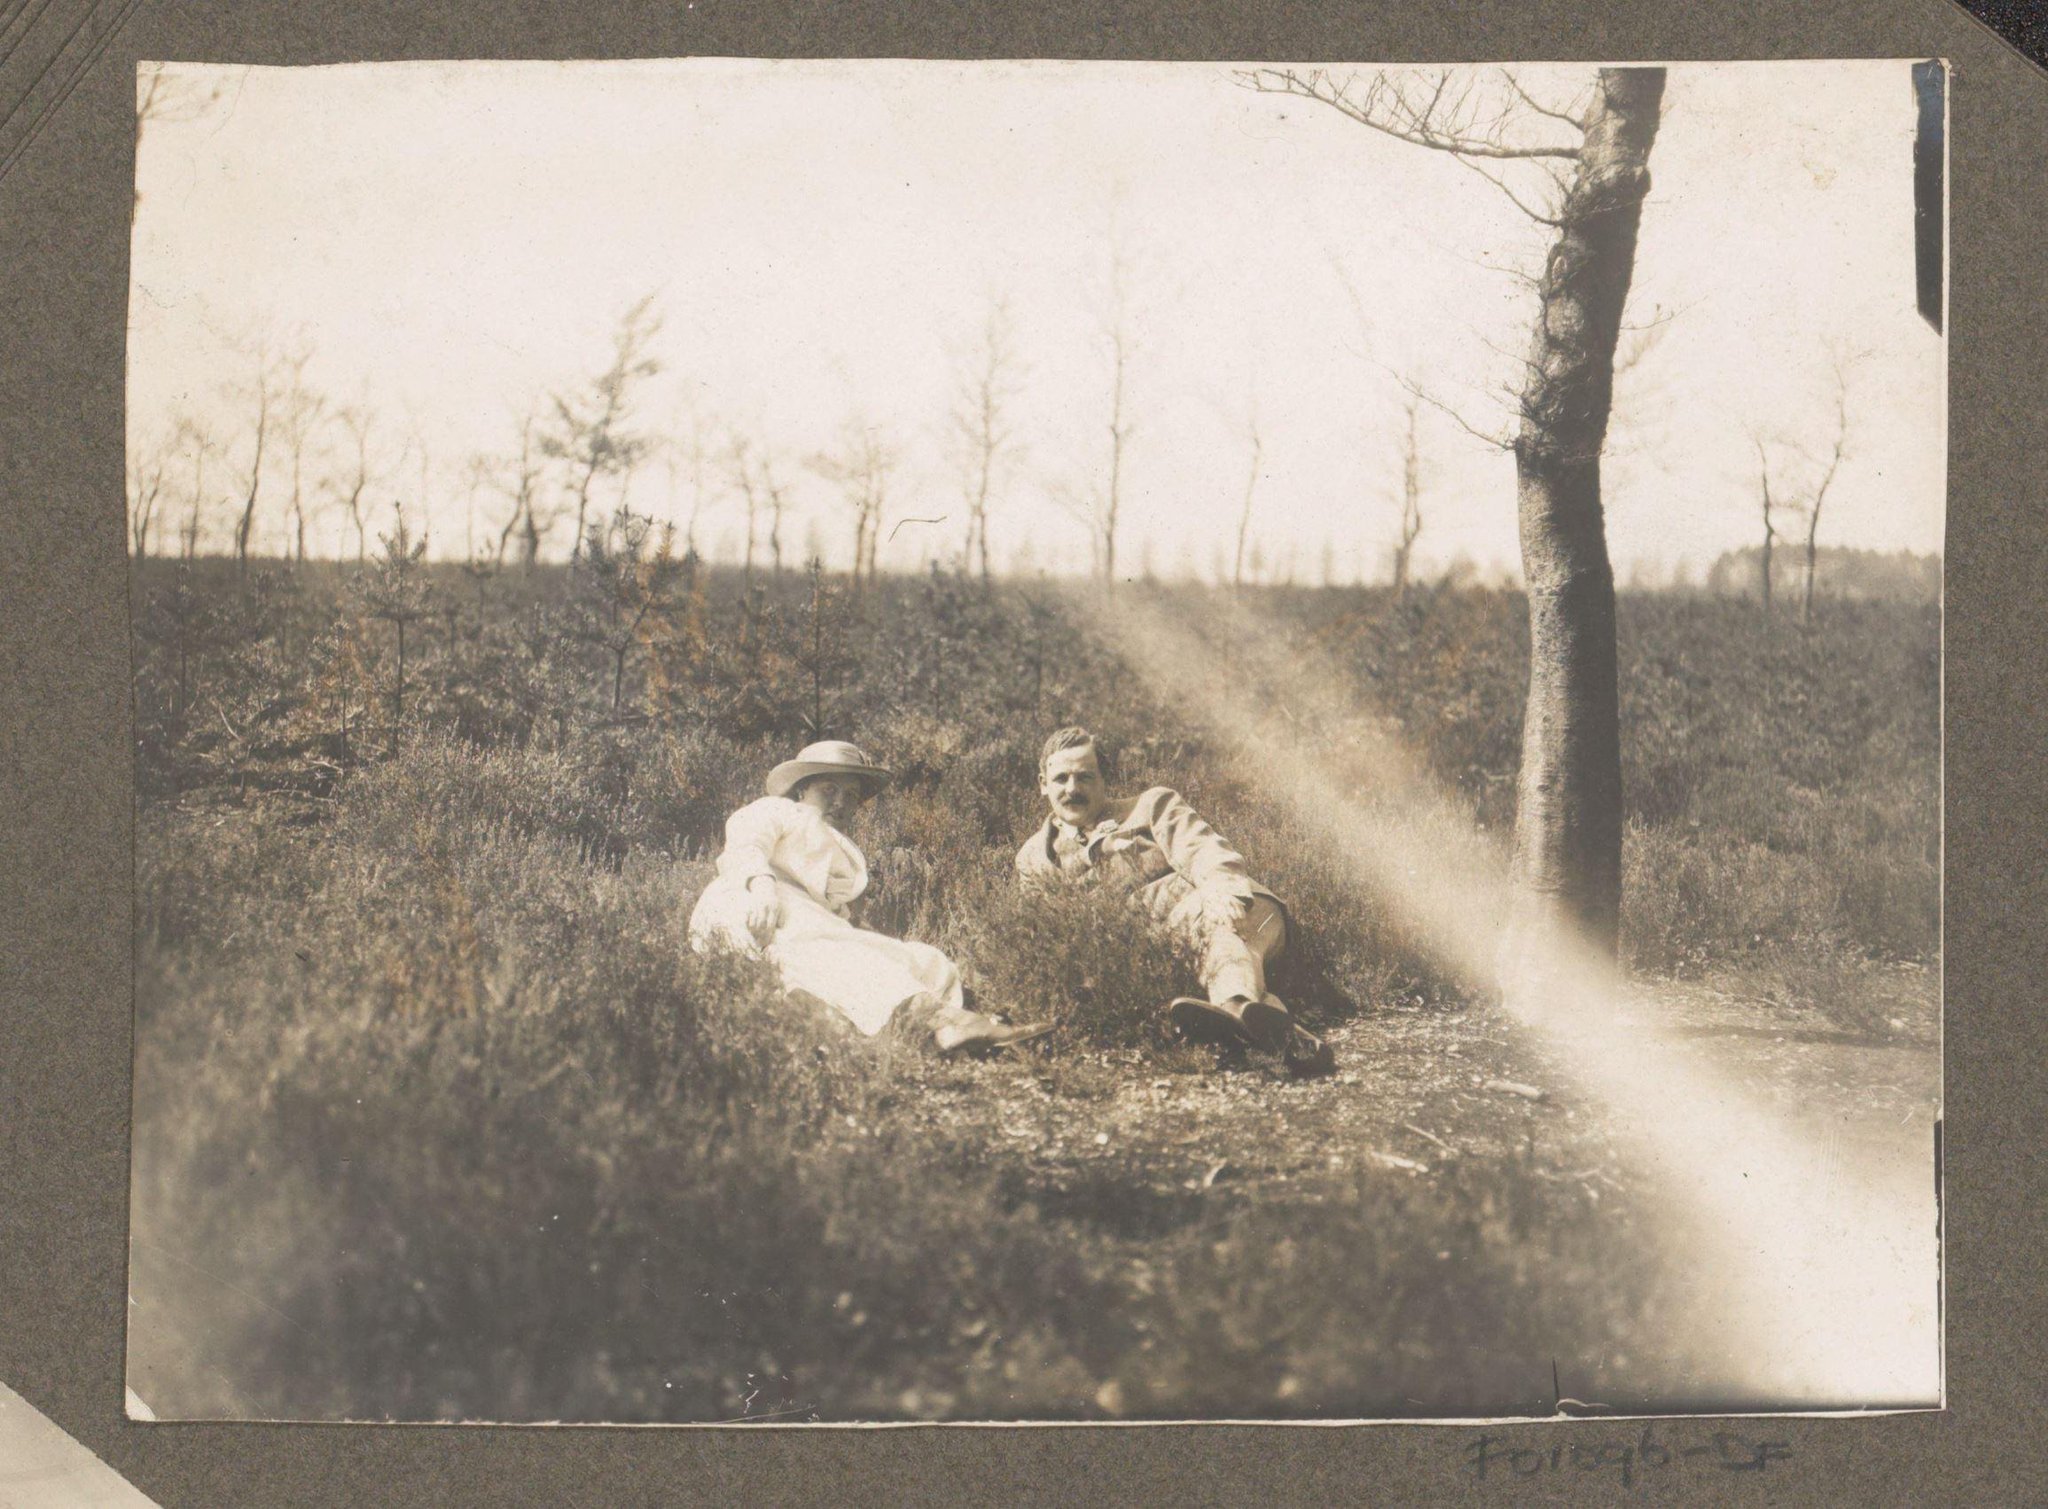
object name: photograph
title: Ruitertafereel op Koninklijke Houtvesterij Het Loo: man en vrouw liggend op een hei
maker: Anonymous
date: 1900-1925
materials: photographic support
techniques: gelatin silver print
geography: het loo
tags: hunting, chase, hunting-ground, resting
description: Onderdeel van Fotoalbum van de heer Brams, opperhoutvester van koningin Wilhelmina op Koninklijke Houtvesterij Het Loo.